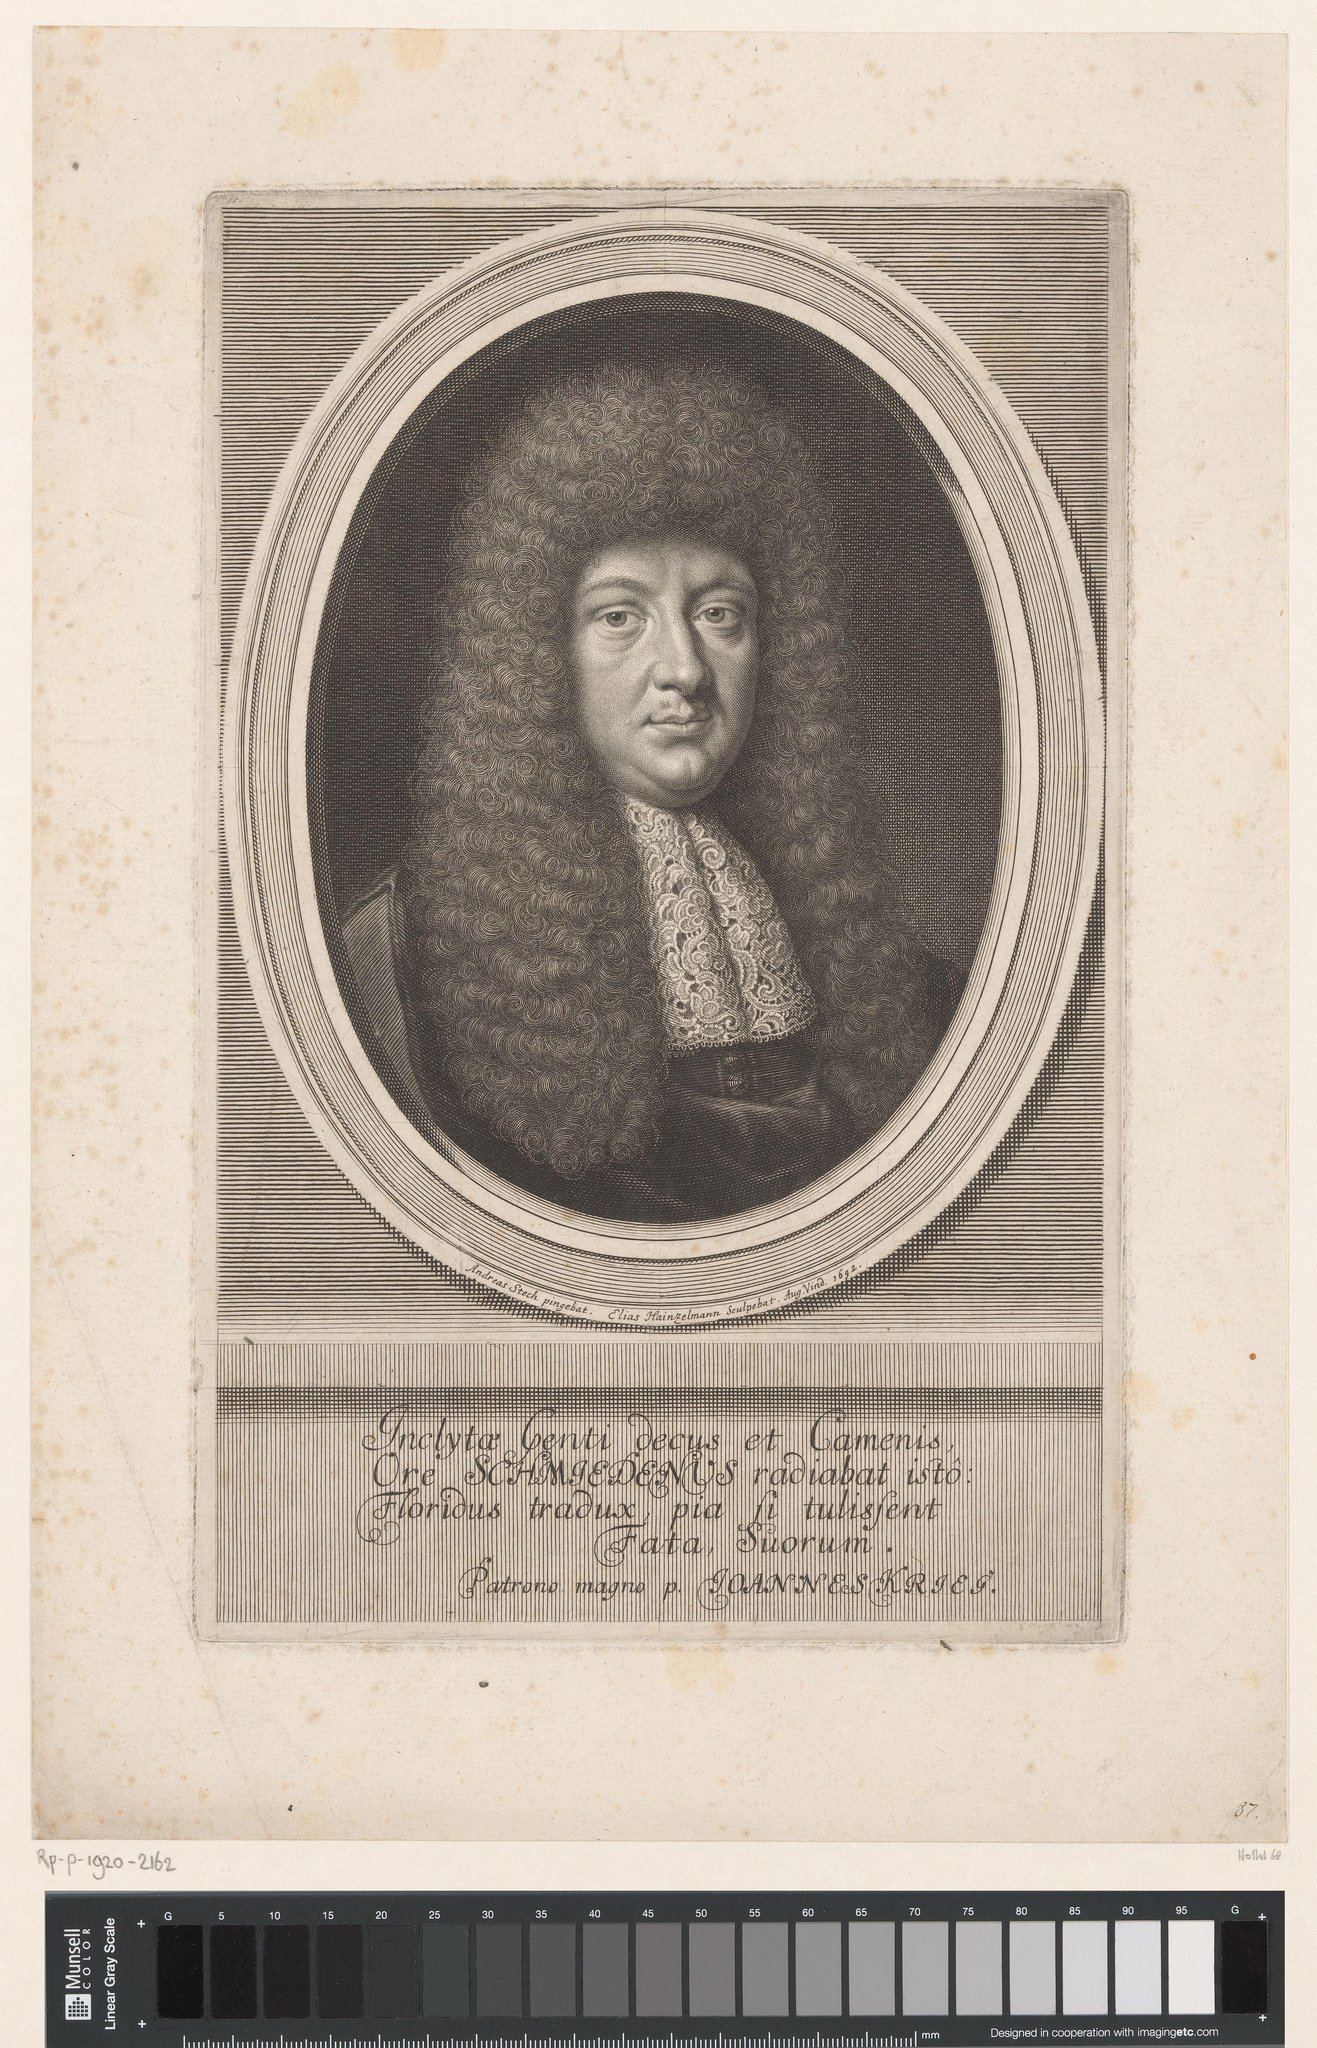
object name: print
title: Portret van Johann Ernst Schmieden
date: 1692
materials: paper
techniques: engraving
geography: augsburg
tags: mayor, mayor, burgomaster, historical persons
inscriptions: collector's mark: Lugt 2228